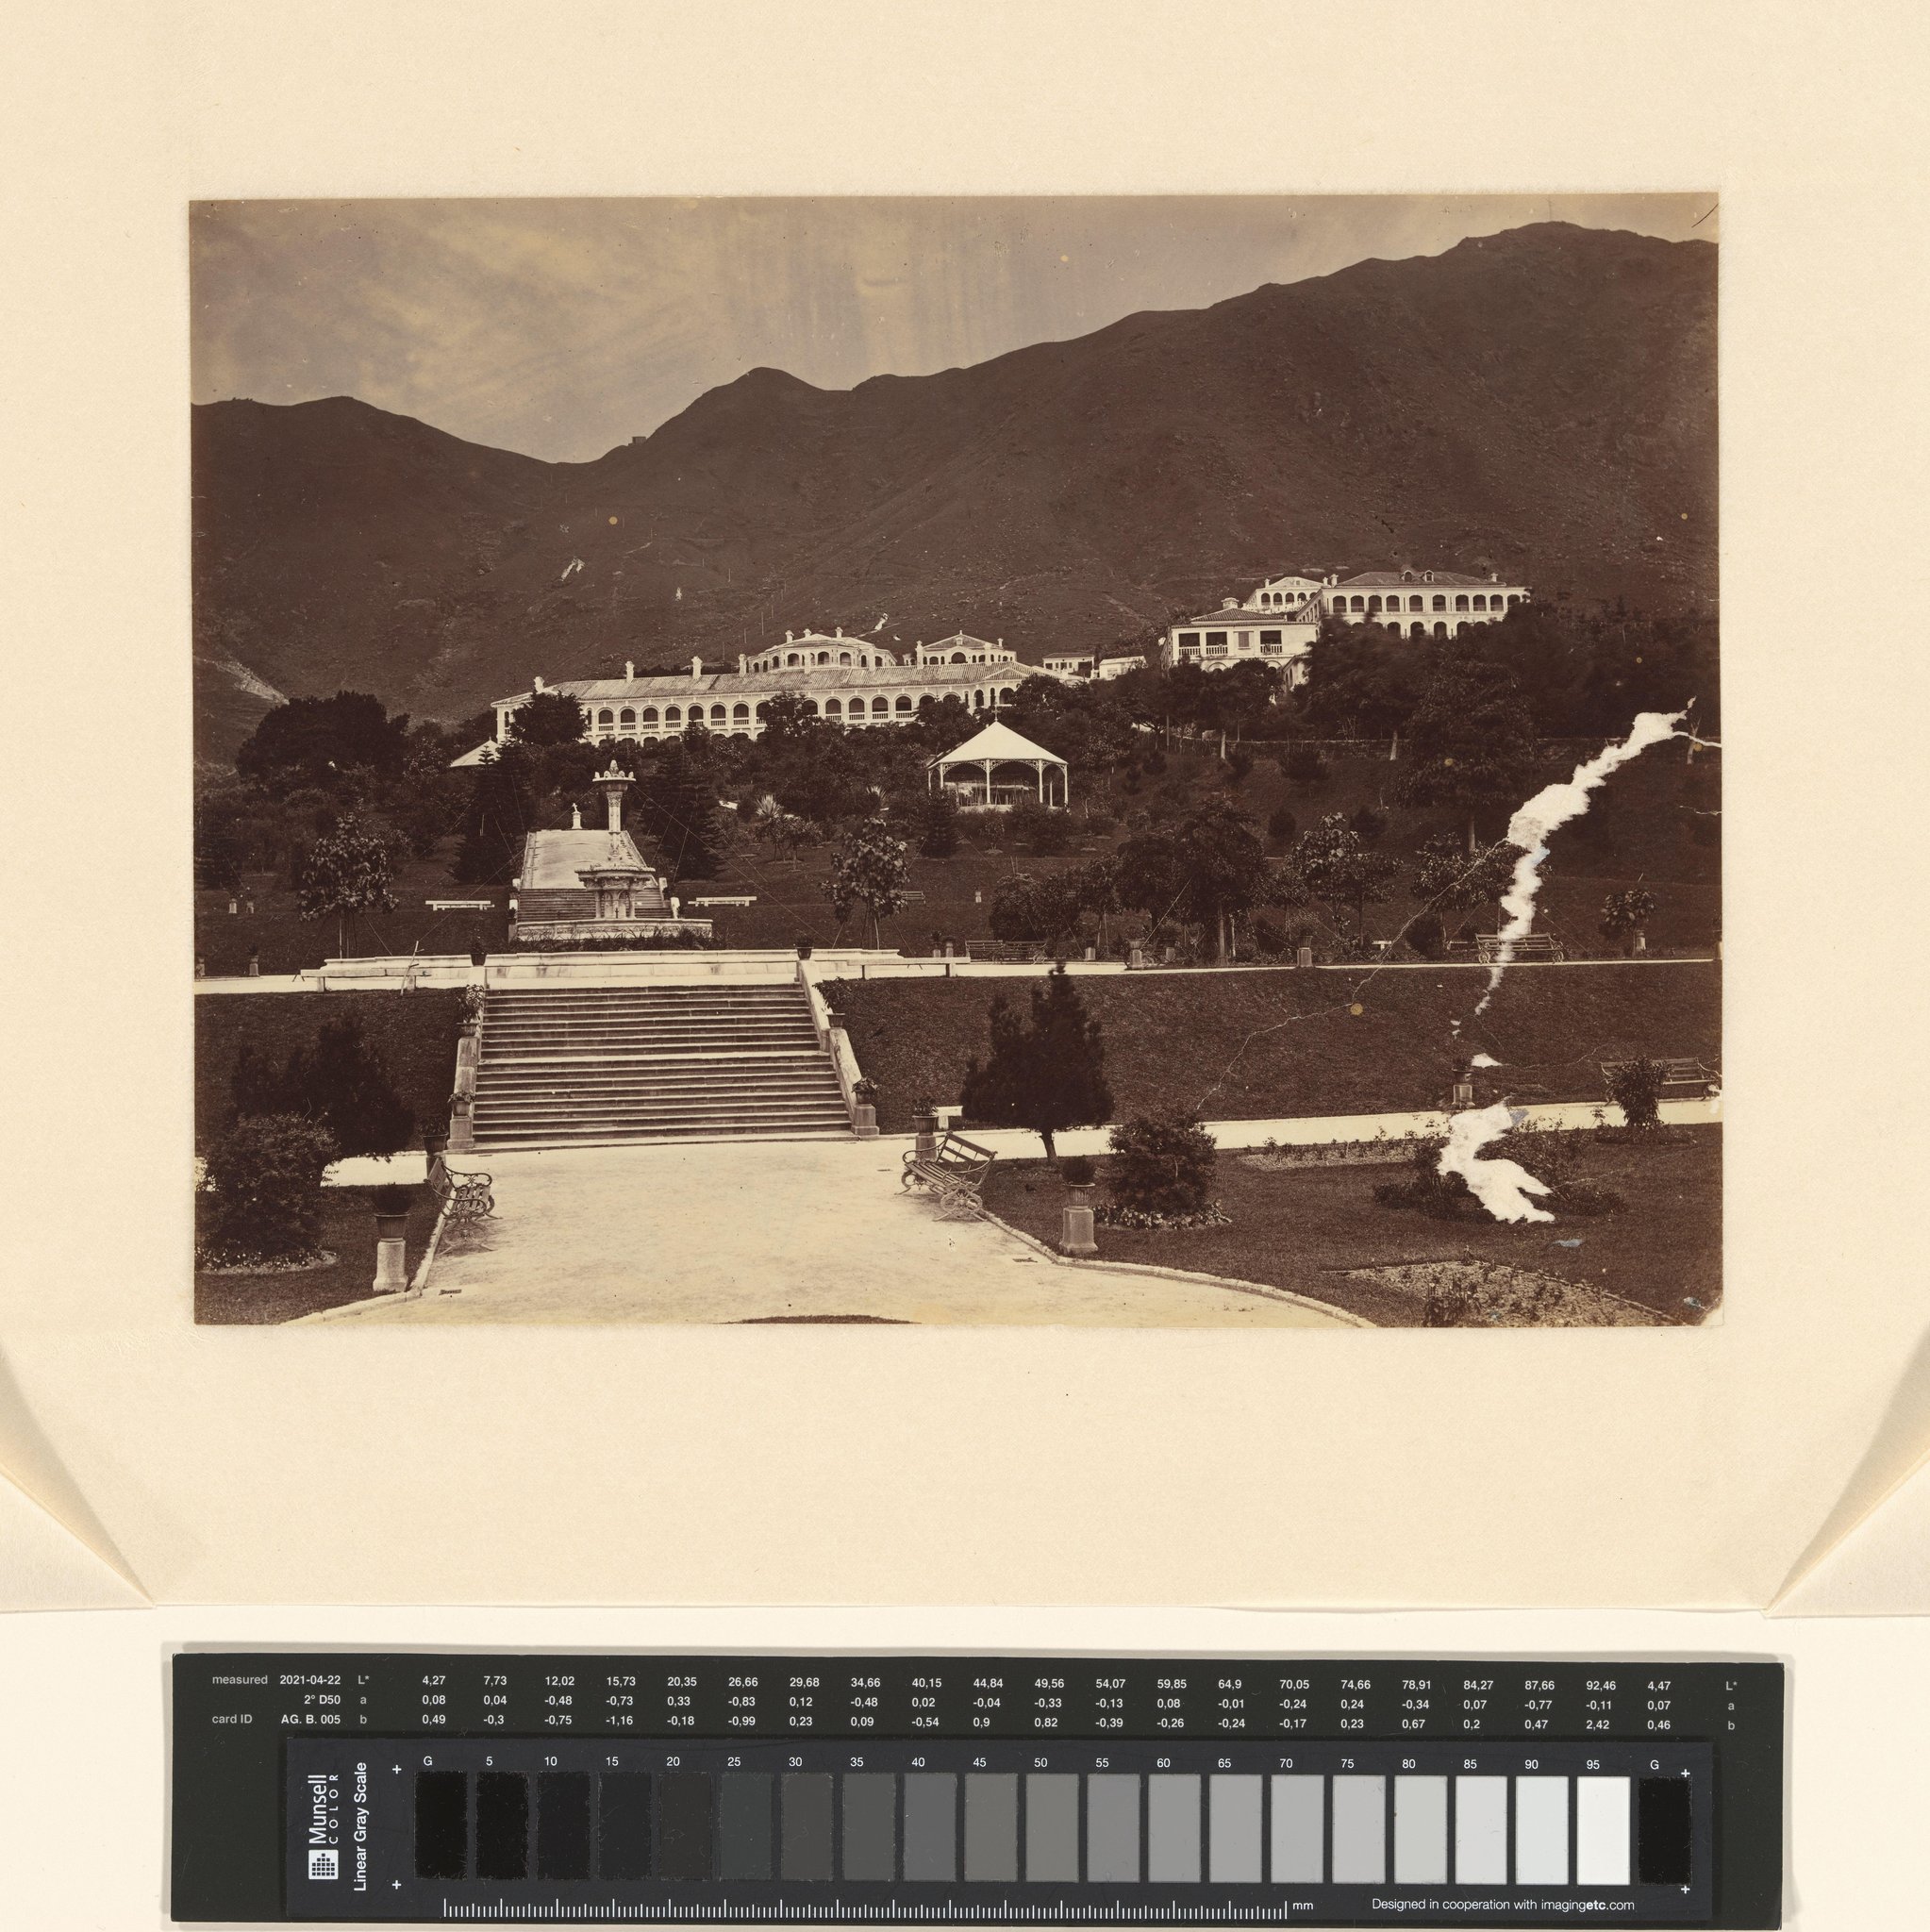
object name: photograph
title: Hong Kong (?)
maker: Anonymous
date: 1865-1875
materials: paper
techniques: albumen print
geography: hong kong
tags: hong kong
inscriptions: number: ‘12’, number: ‘164’, inscription: ‘... Garden Library Hongkong’